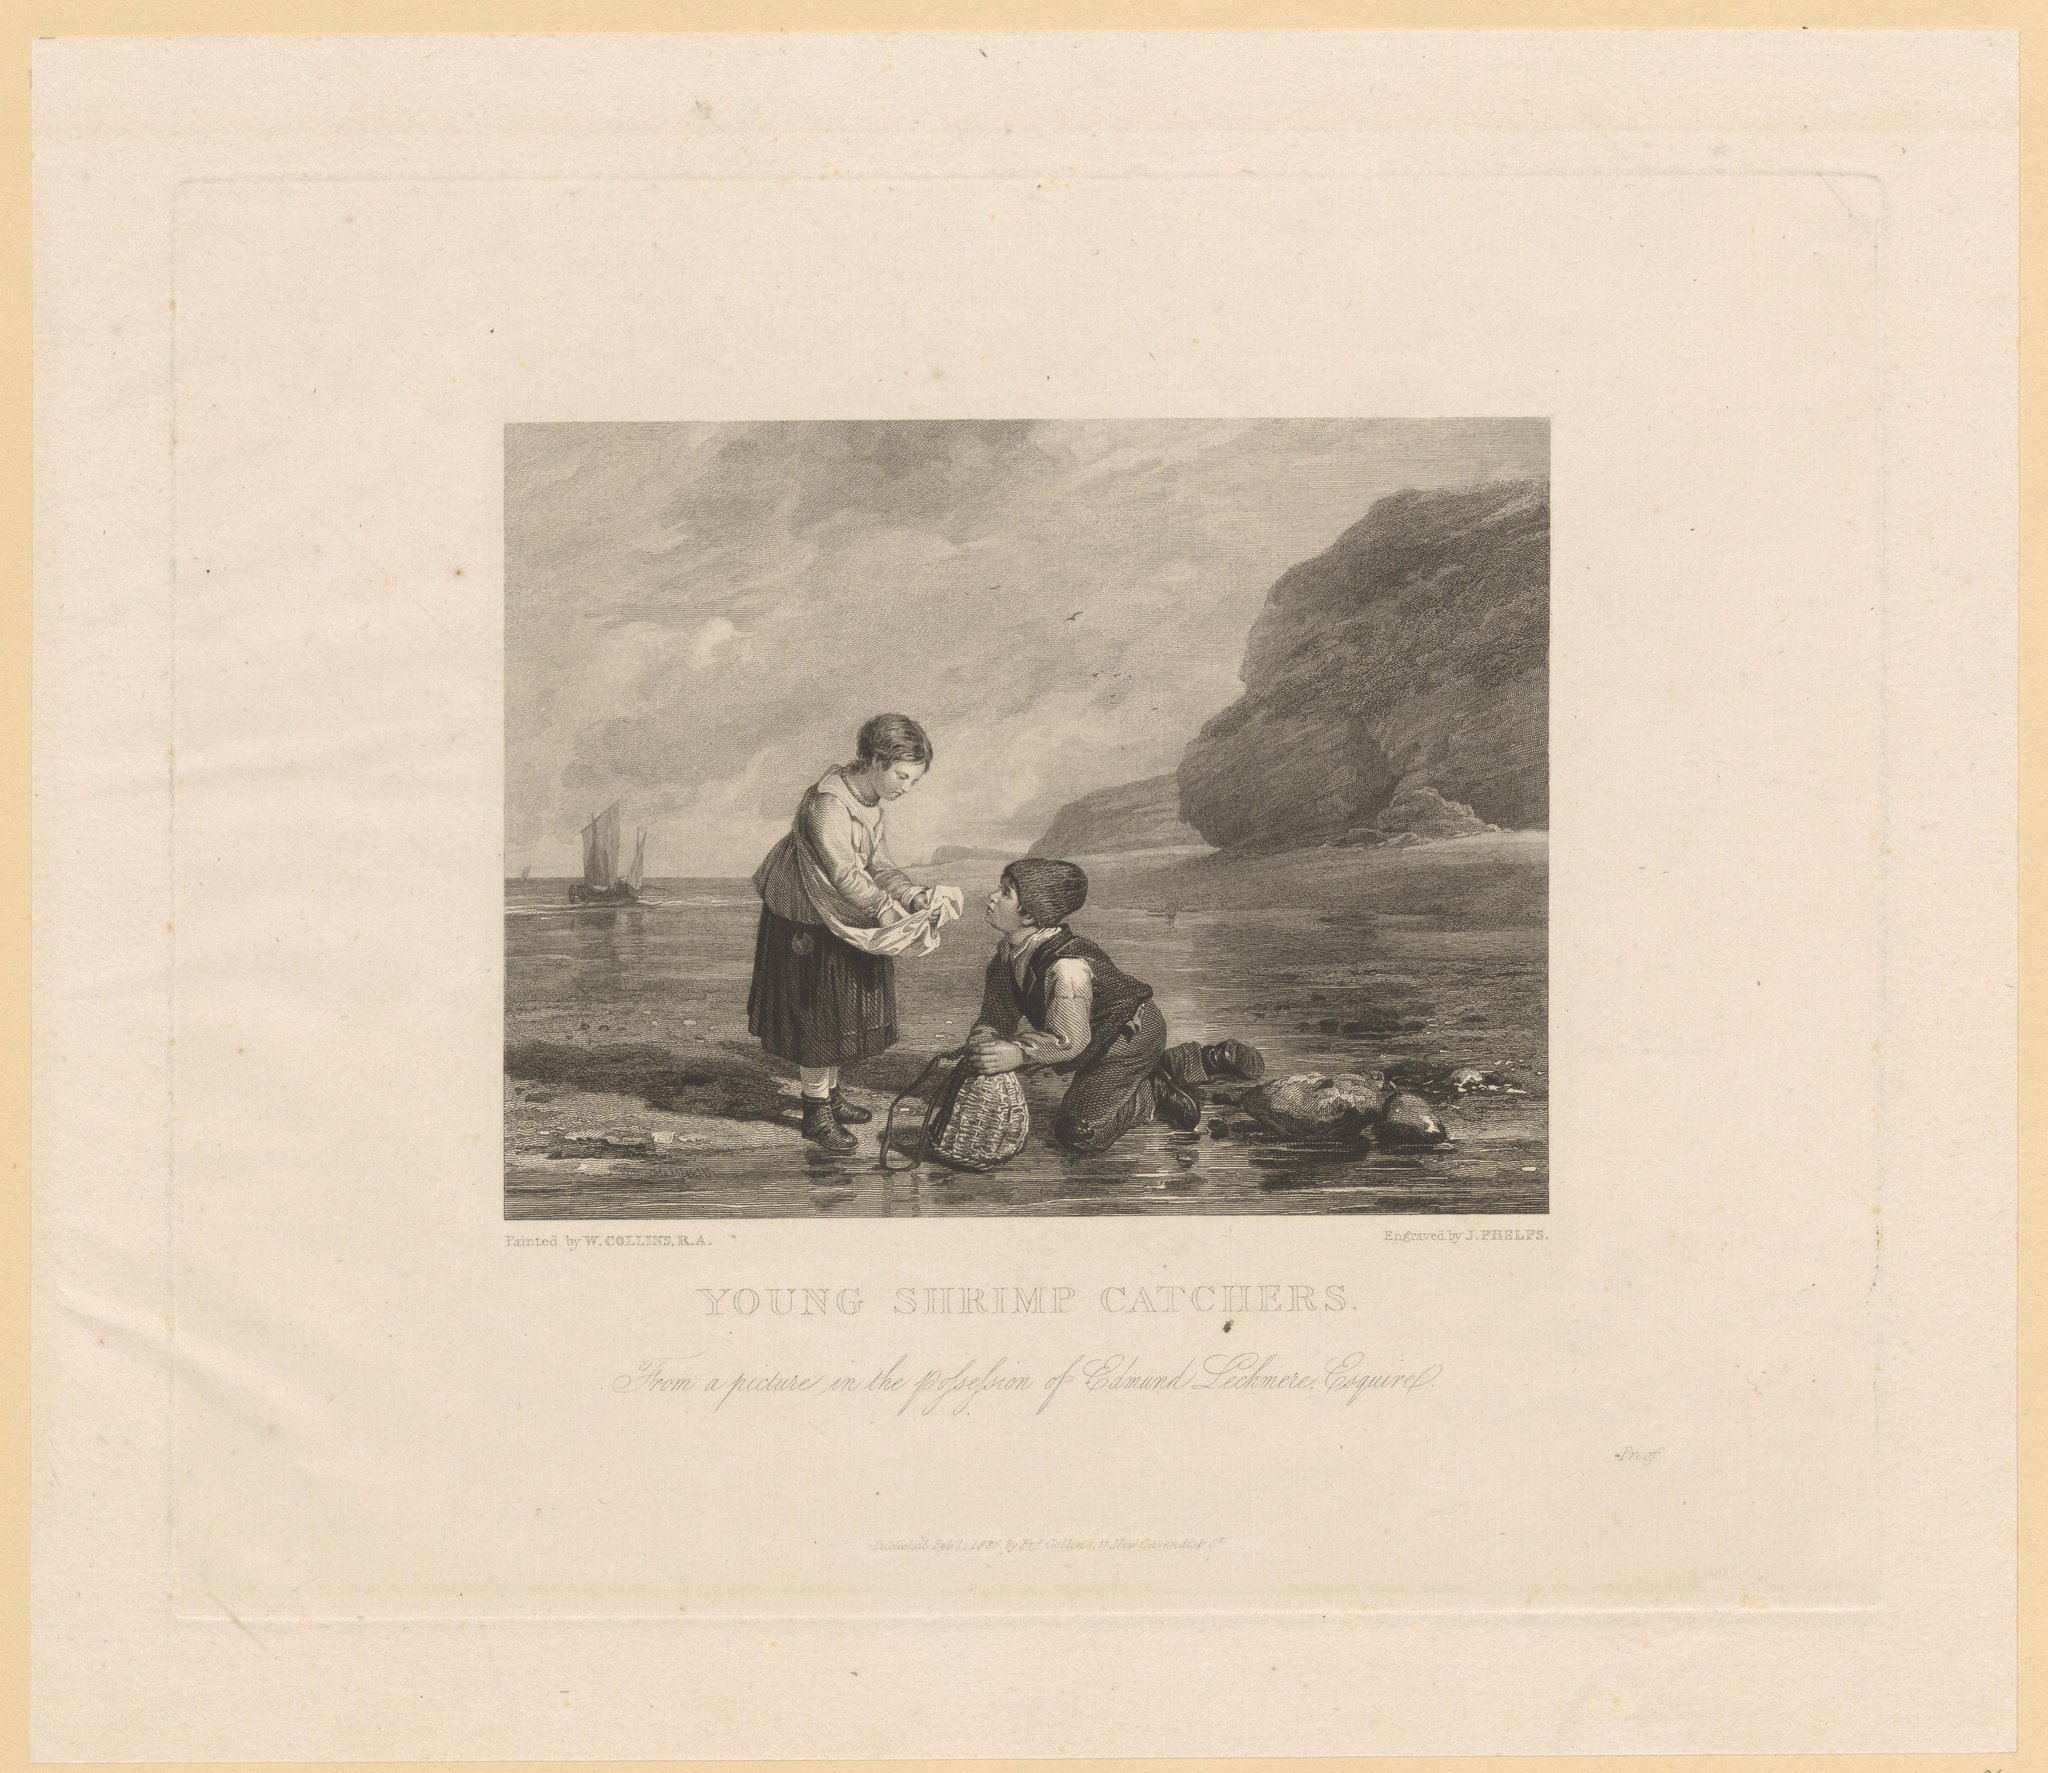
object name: print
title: Twee kinderen op een strand vangen garnalen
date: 1802-1826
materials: paper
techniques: etching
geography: london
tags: sailing-ship, sailing-boat, beach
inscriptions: collector's mark: Lugt 12